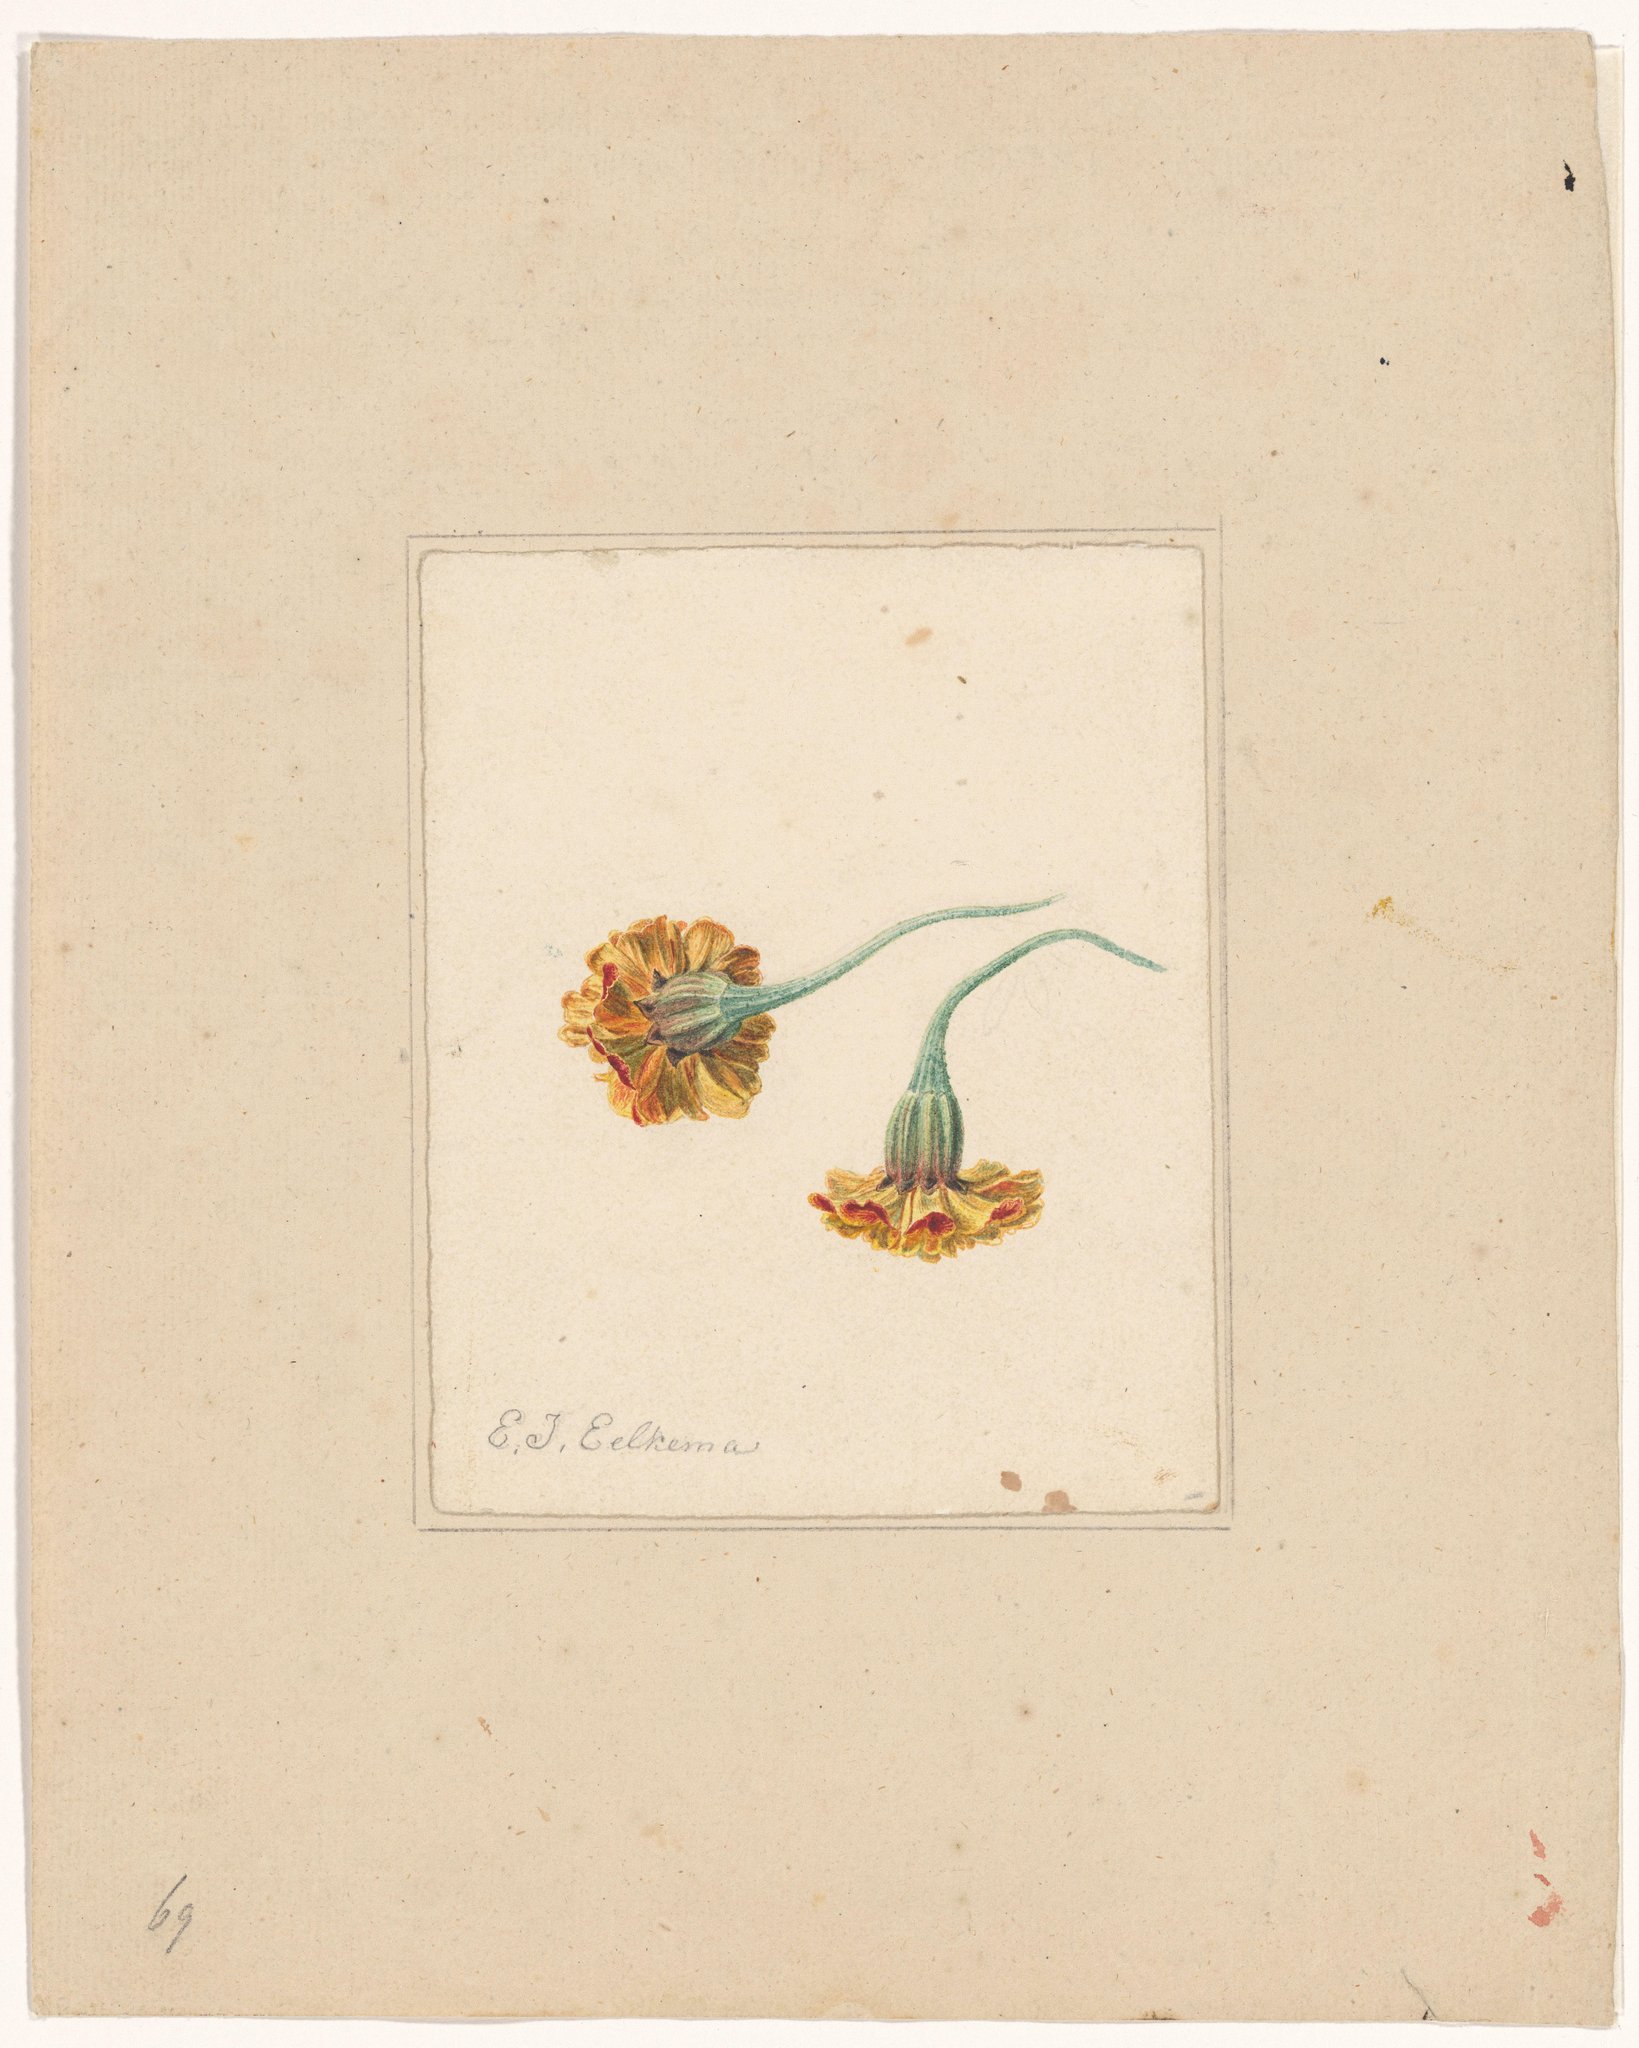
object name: drawing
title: Klein Streepzaad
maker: eelke jelles eelkema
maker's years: 1788-1839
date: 1815-1830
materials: paper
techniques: drawing